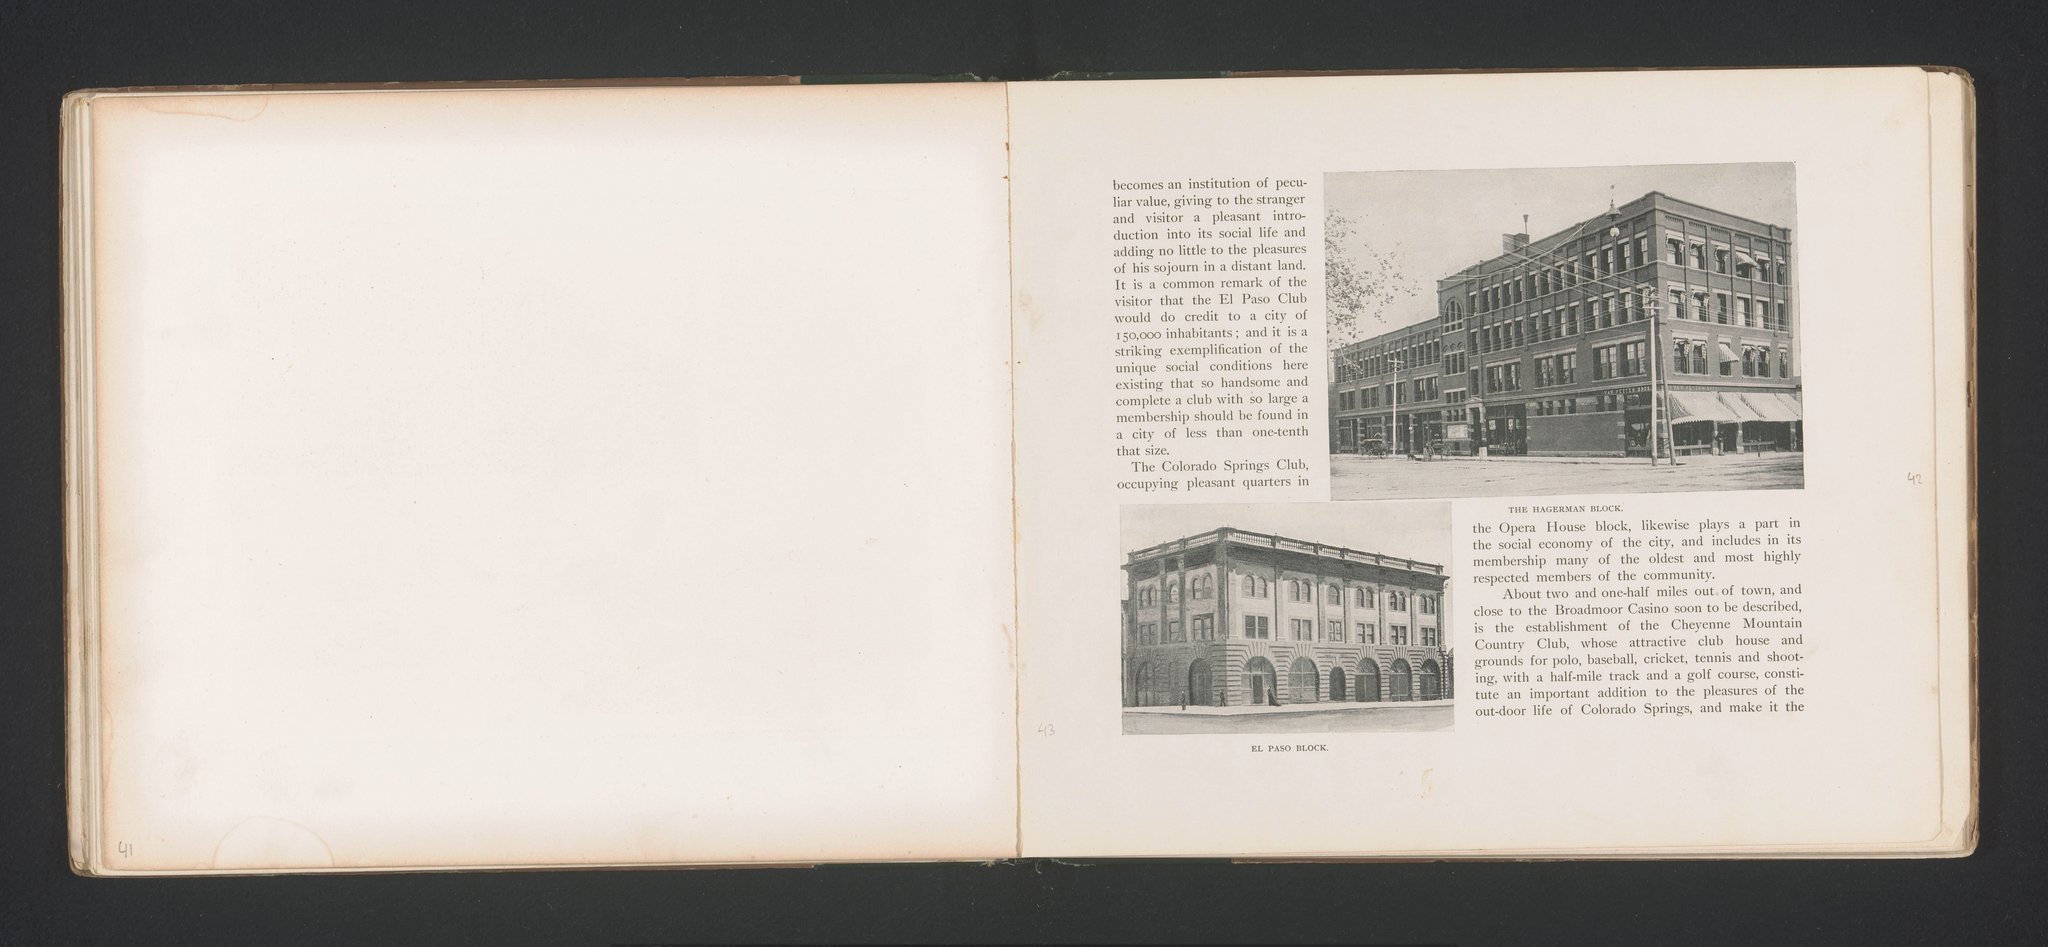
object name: photomechanical print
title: The Hagerman block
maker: Anonymous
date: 1888-1893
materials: paper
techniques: autotype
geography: new york city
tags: façade (of house or building), street